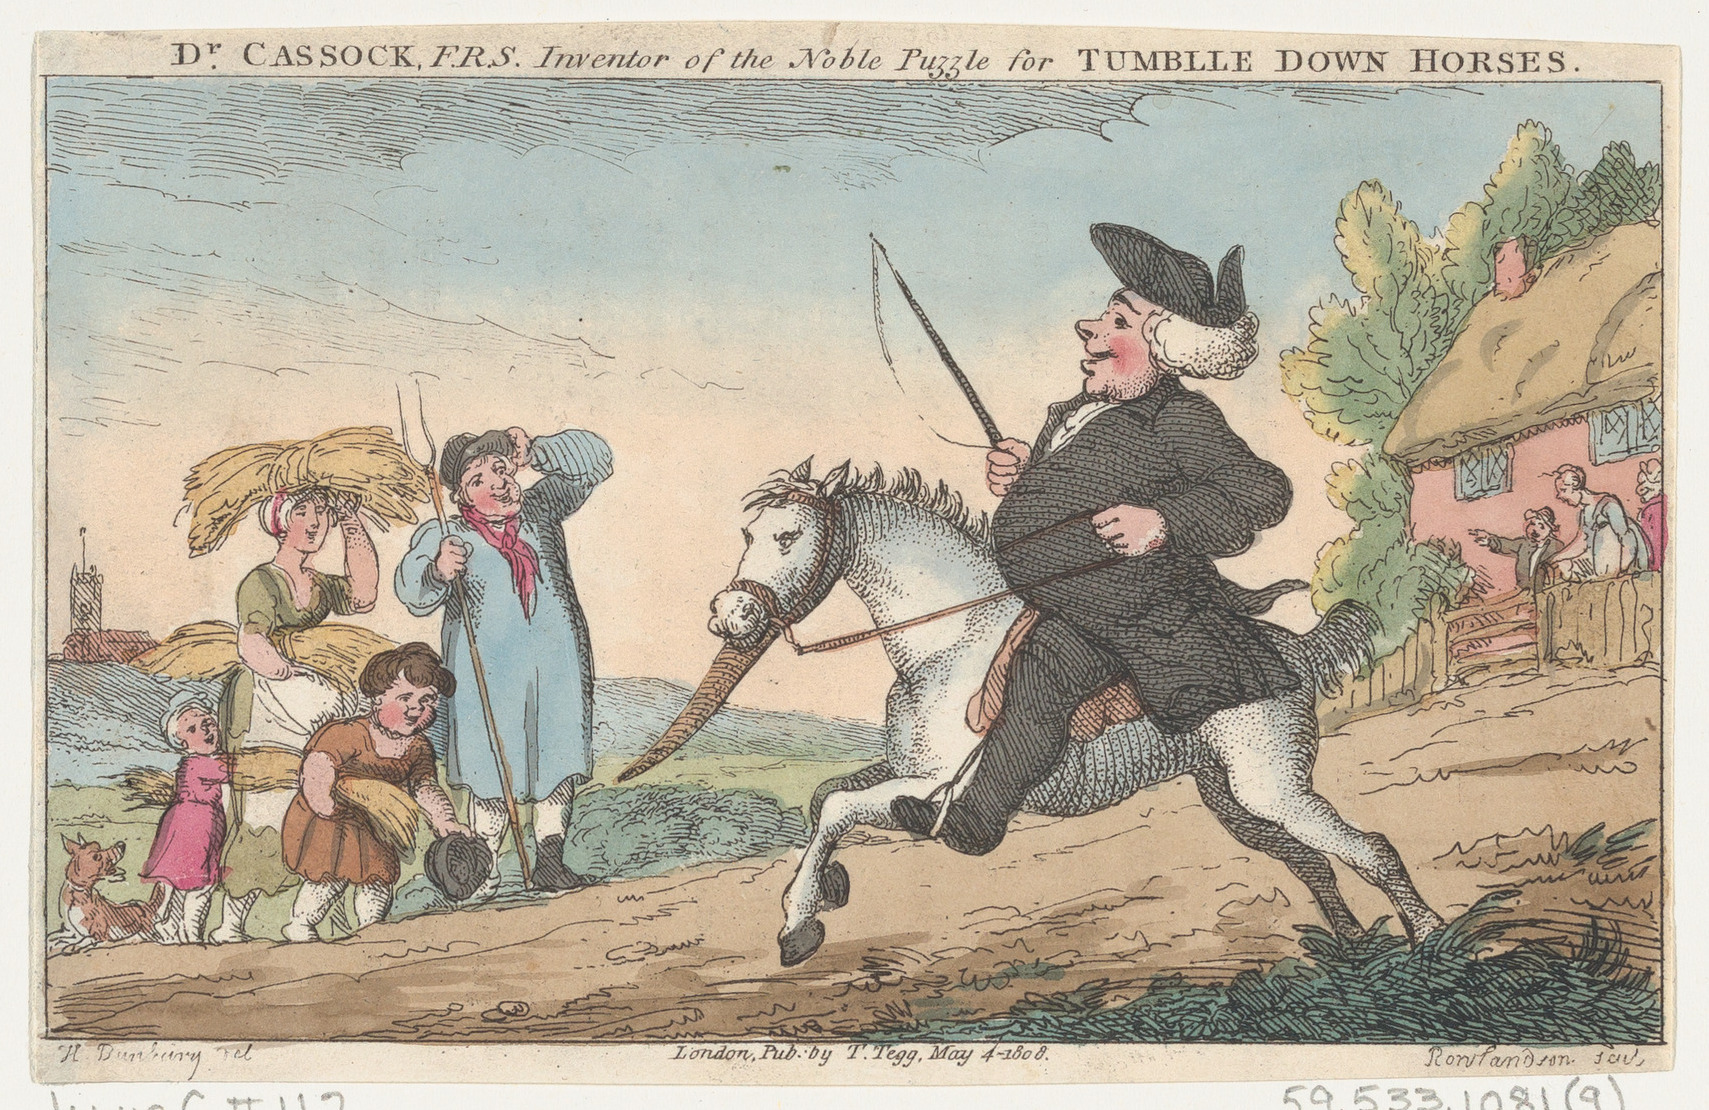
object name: print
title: Dr. Cassock, F.R.S., Inventor of the Noble Puzzle for Tumble Down Horses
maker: thomas rowlandson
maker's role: artist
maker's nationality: british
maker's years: 1757-1827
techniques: etching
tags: satire,men,women,horses